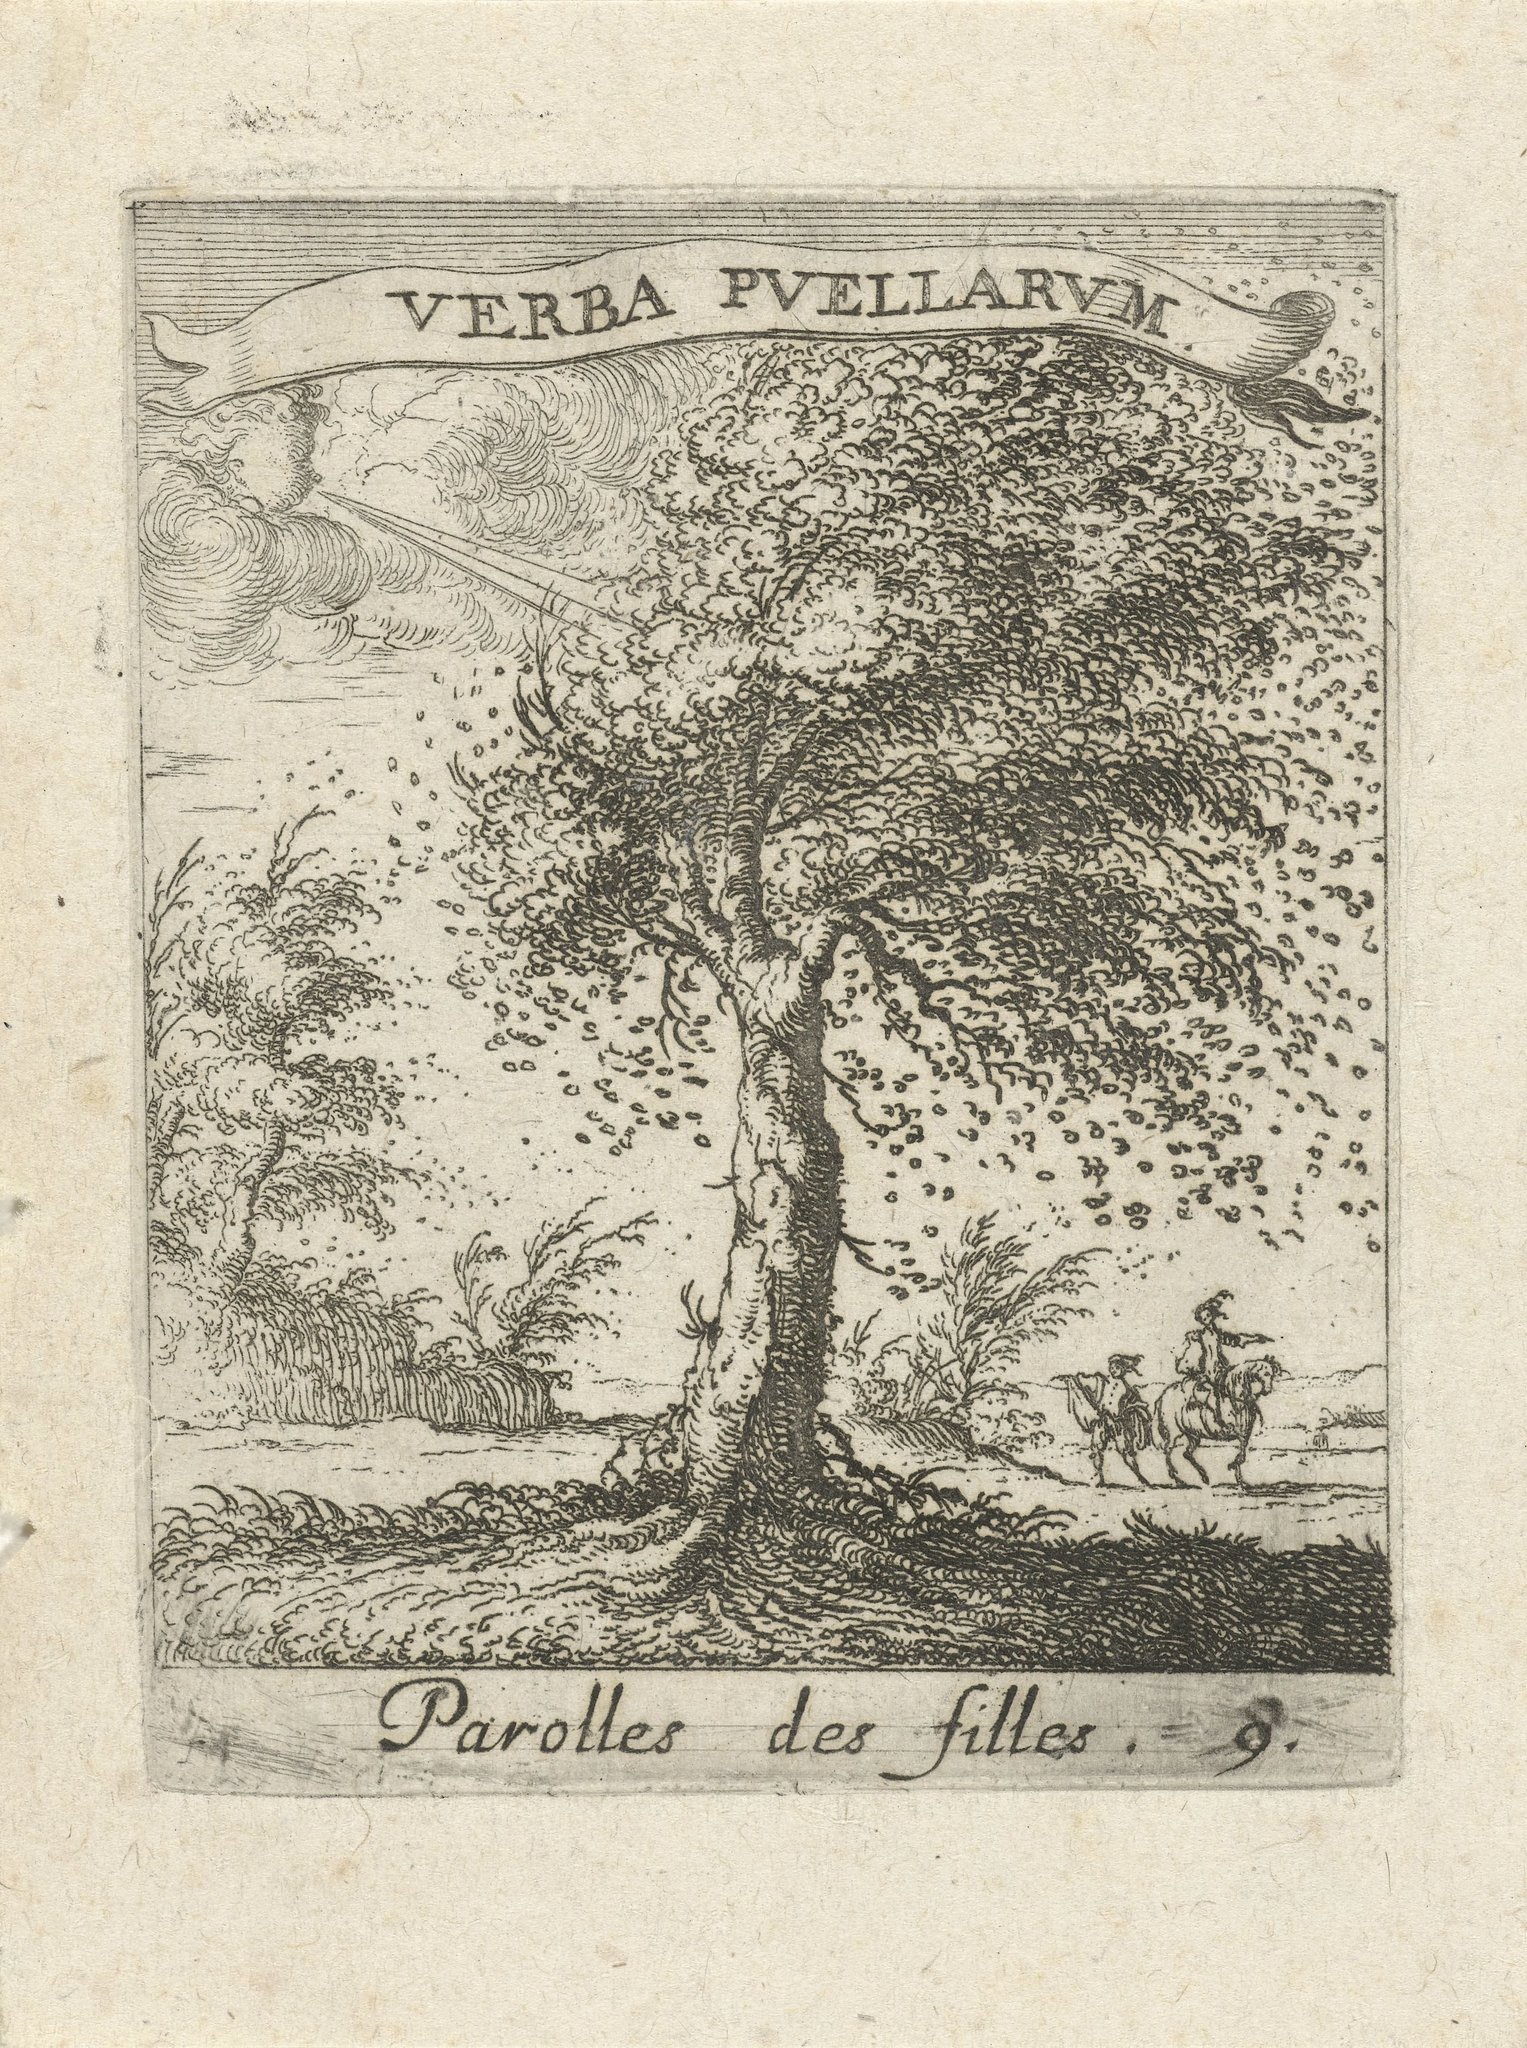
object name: print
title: Landschap met boom in de wind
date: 1672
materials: paper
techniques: etching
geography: paris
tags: qualities of love: first series (+ emblematical representation of concept)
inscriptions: collector's mark: Lugt 2166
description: De wind blaast de bladeren van een boom. Op de achtergrond twee personen, waarvan één te paard. Op een banderol een devies in Latijn en een onderschrift in Frans, beide over de liefde.